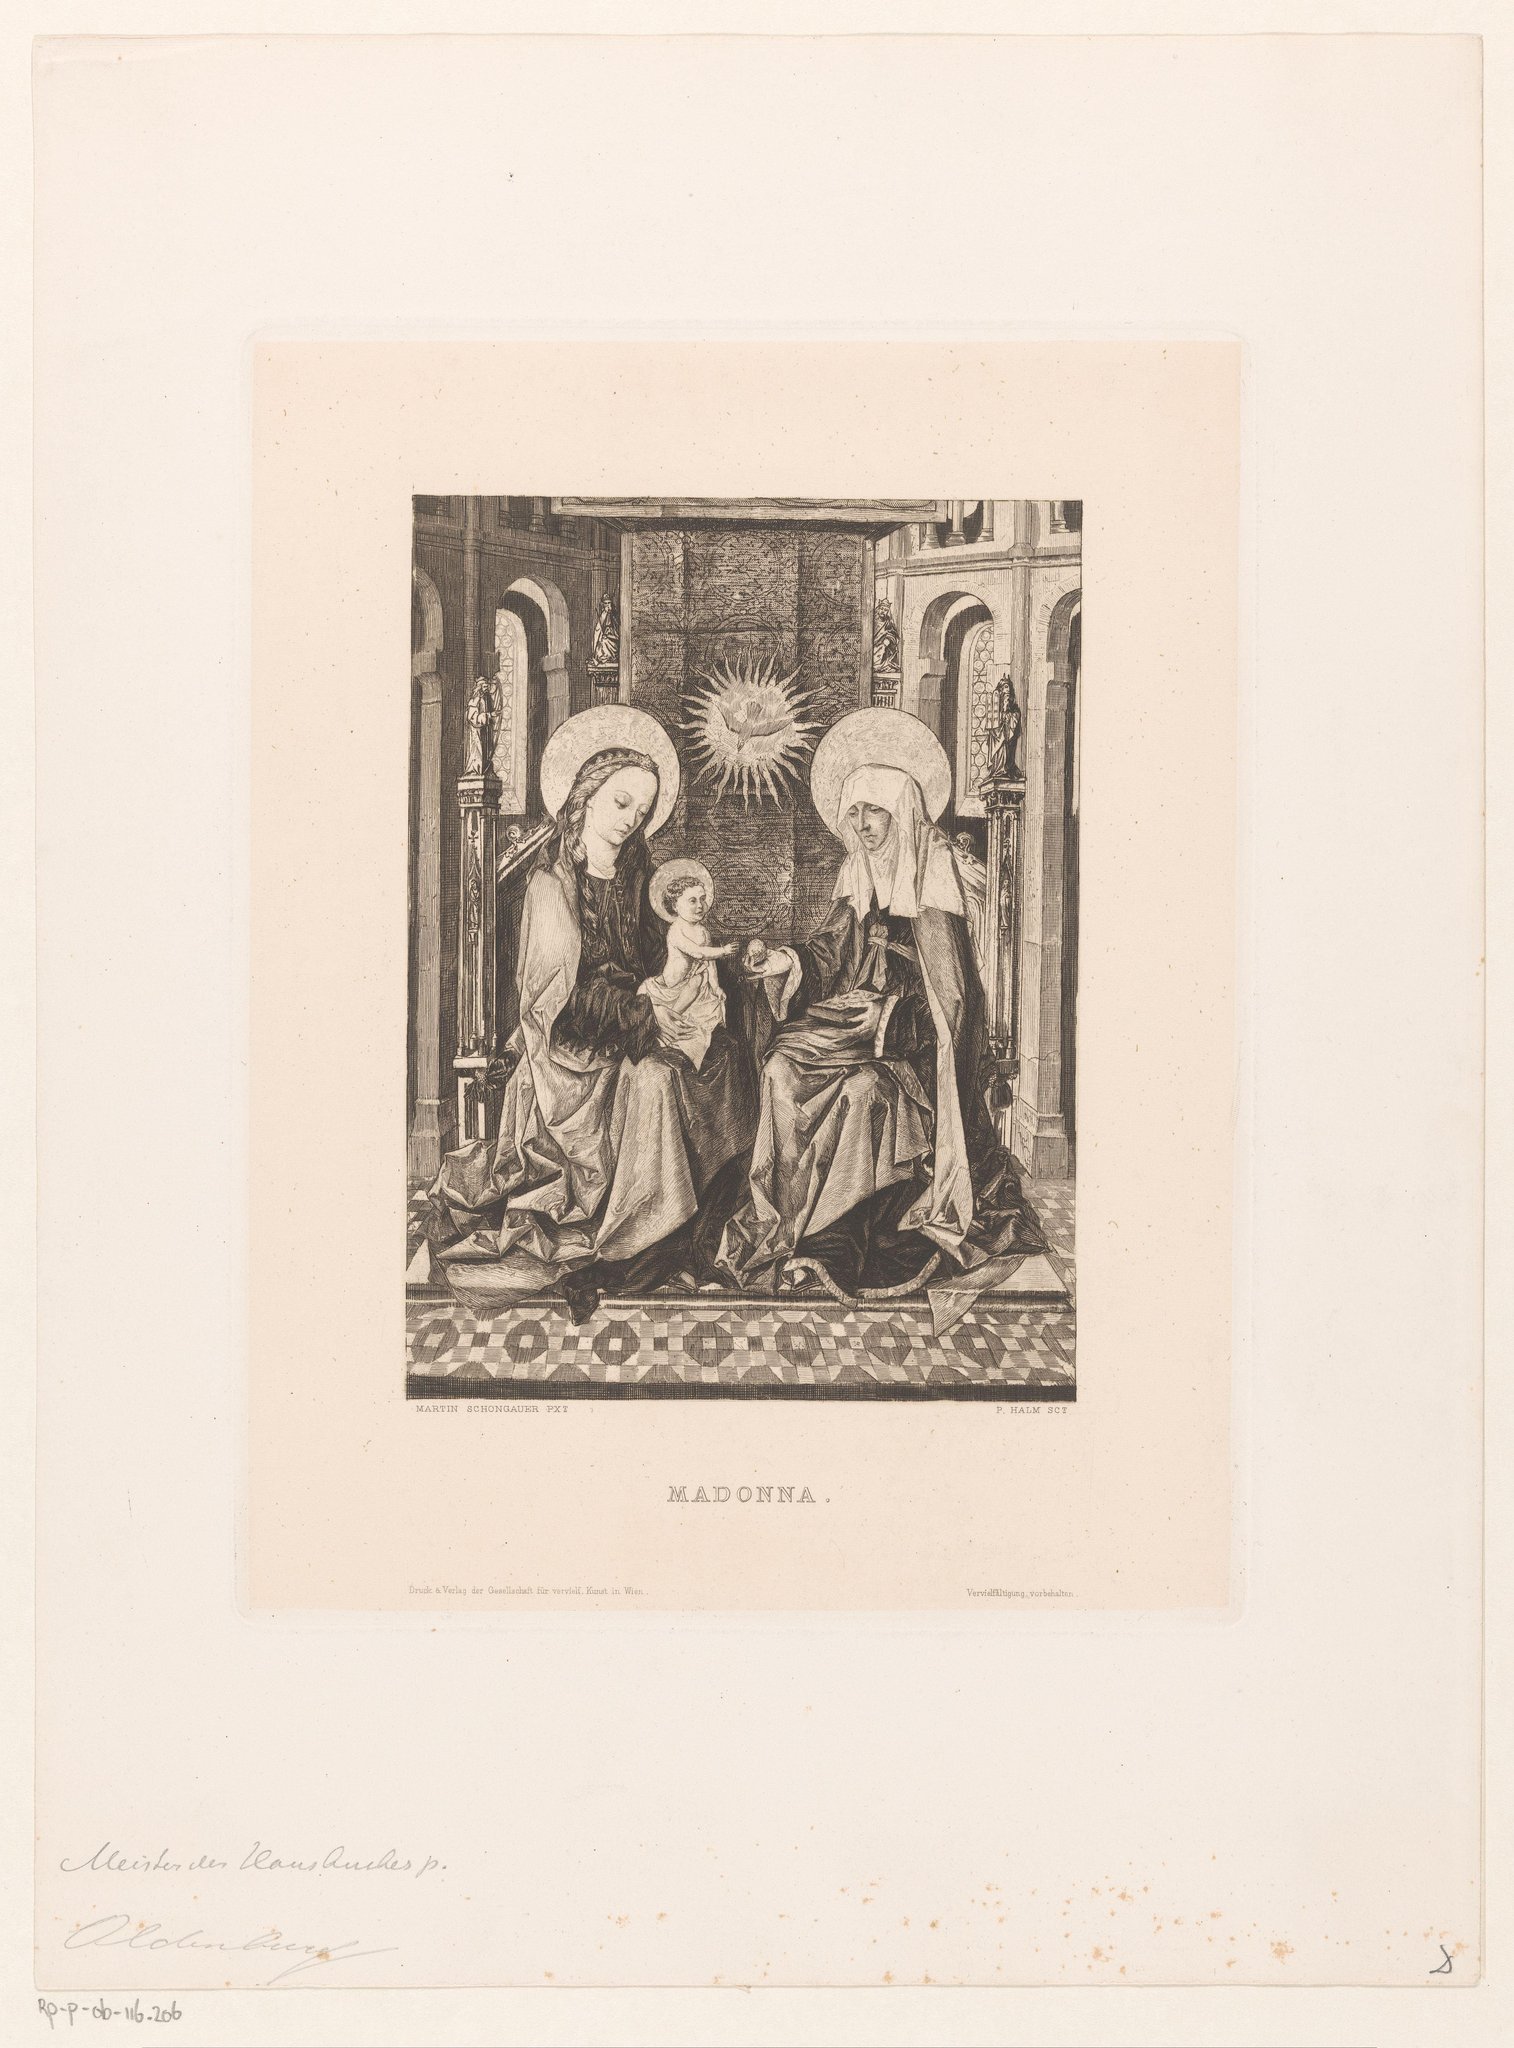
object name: print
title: Madonna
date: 1864-1923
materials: paper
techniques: etching, roulette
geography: vienna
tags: holy family with others, e.g.: anna, groups of persons from the old testament, holy ghost represented as a dove (in flames)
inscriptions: collector's mark: Lugt 2228